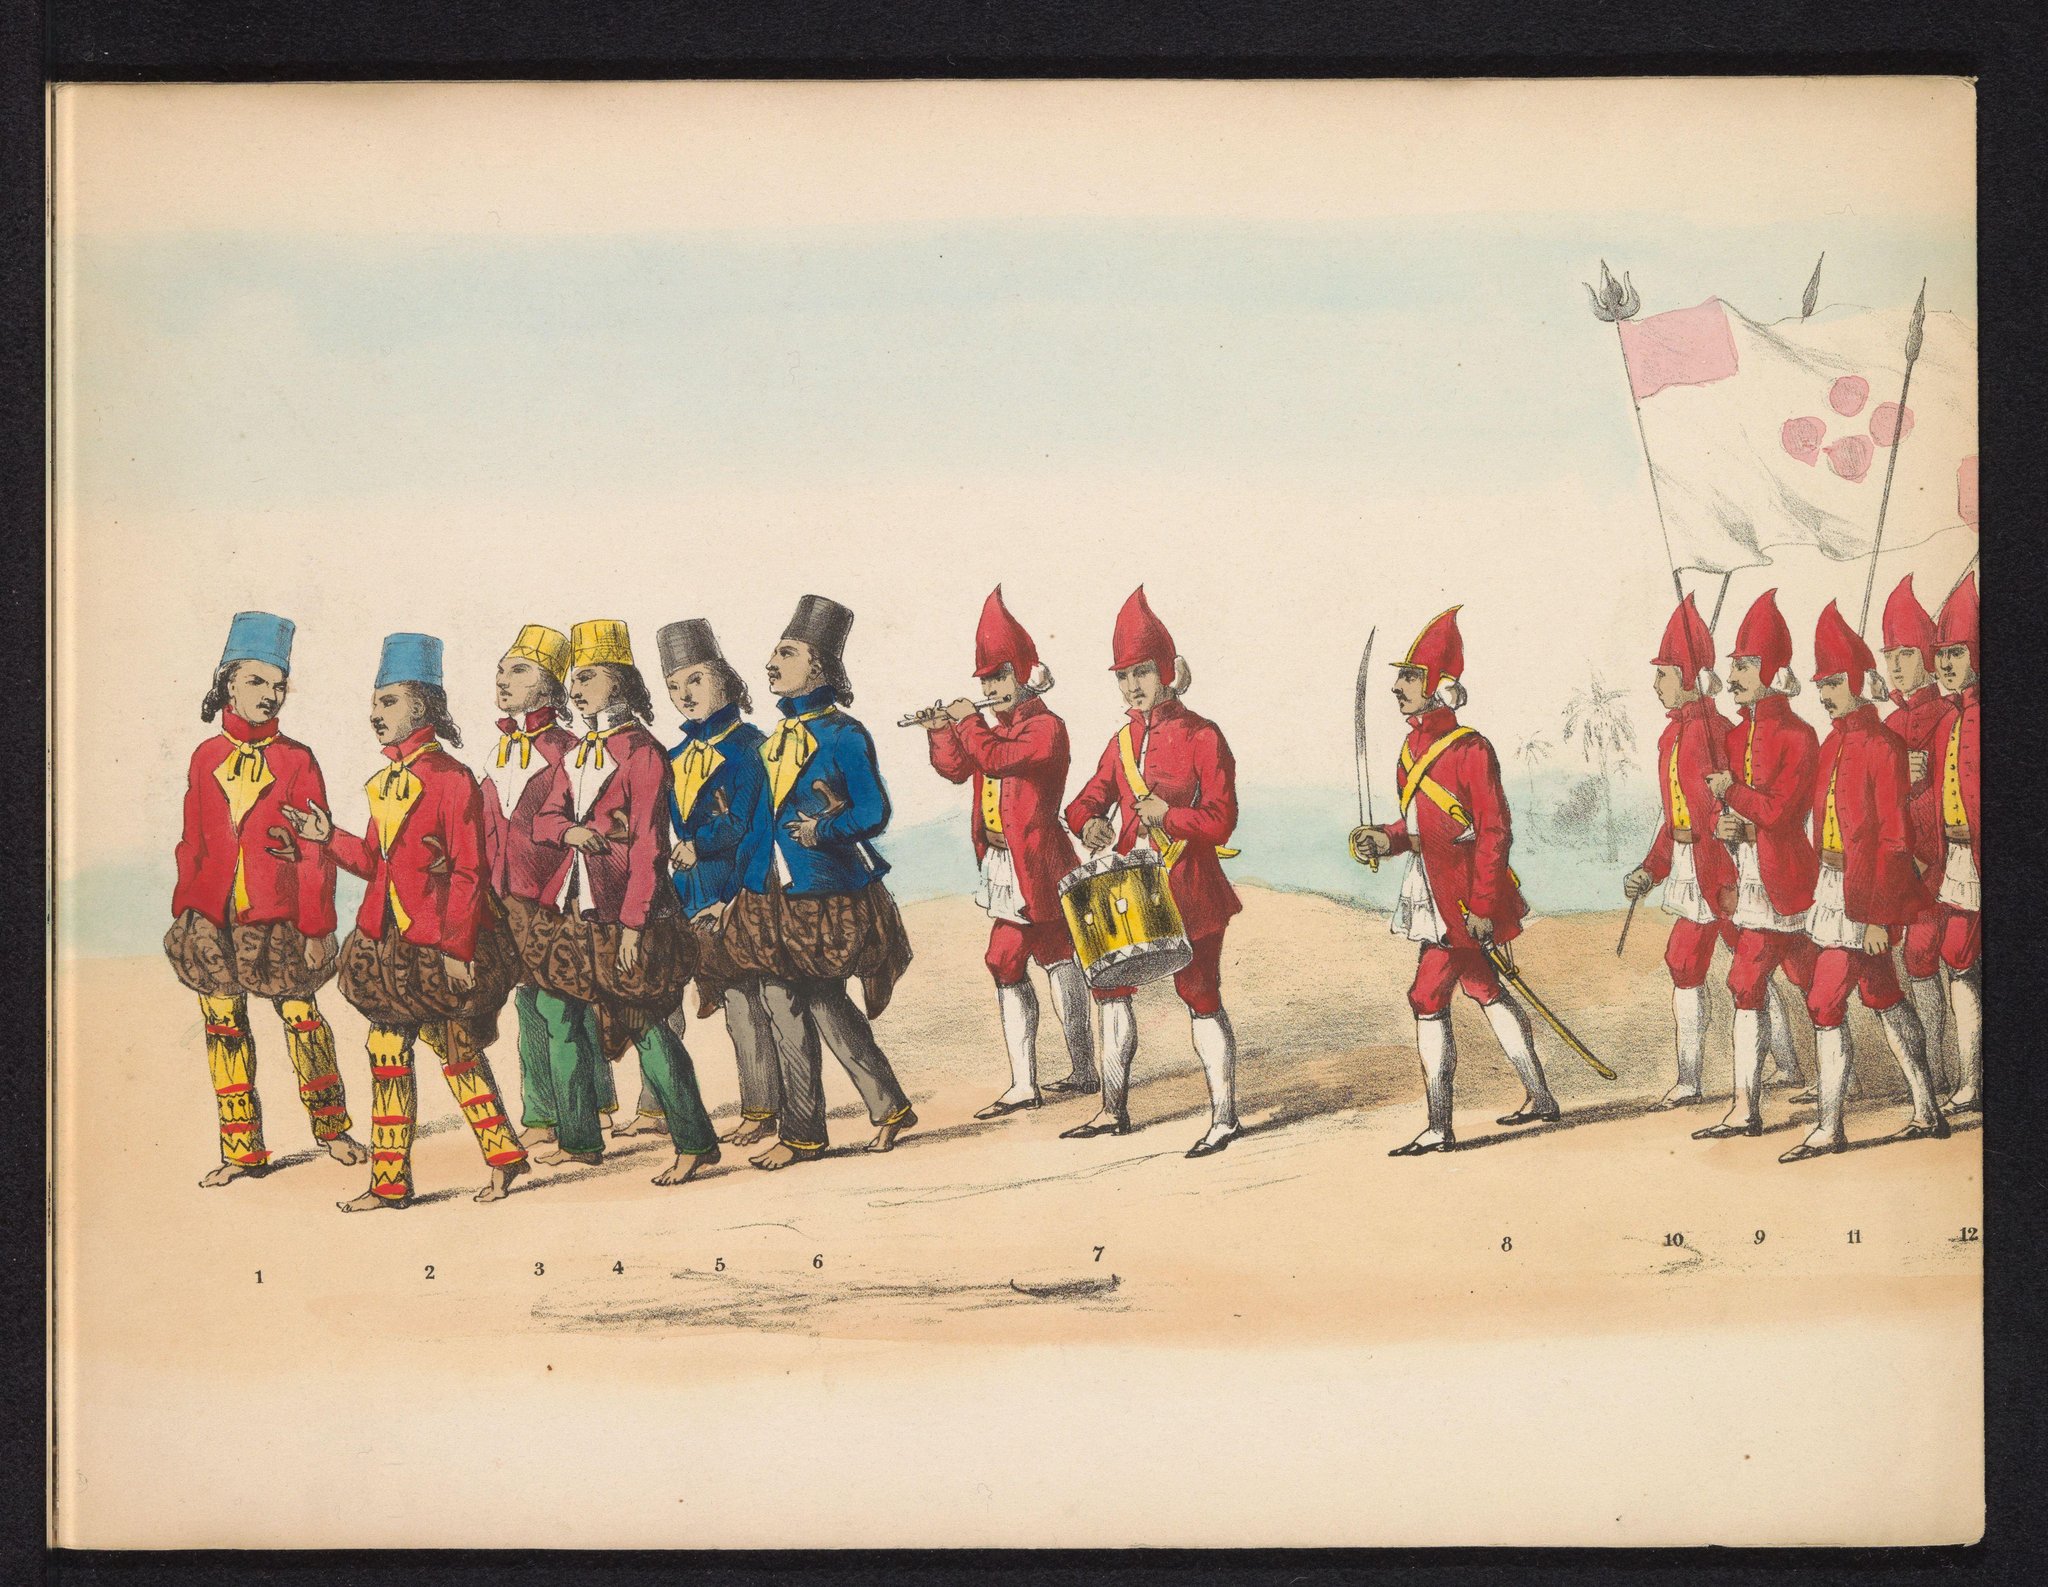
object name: print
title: Maskerade van de Delftse studenten, 1857 (plaat 1)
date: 1857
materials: paper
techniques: hand coloring, lithograph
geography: netherlands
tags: university, students' pageant, costumes used in pageants, delft, dutch east indies, the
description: Gekostumeerde optocht van de studenten van de Koninklijke Akademie te Delft op 5 mei 1857. De optocht verbeeldt de Garebeg optocht van de sultan van Djokjakarta plus verschillende karakteristieke types uit de Indonesische archipel. Eerste plaat met de groepen genummerd 1-21. Onderdeel van de serie van acht en een half aanelkaar geplakte bladen.